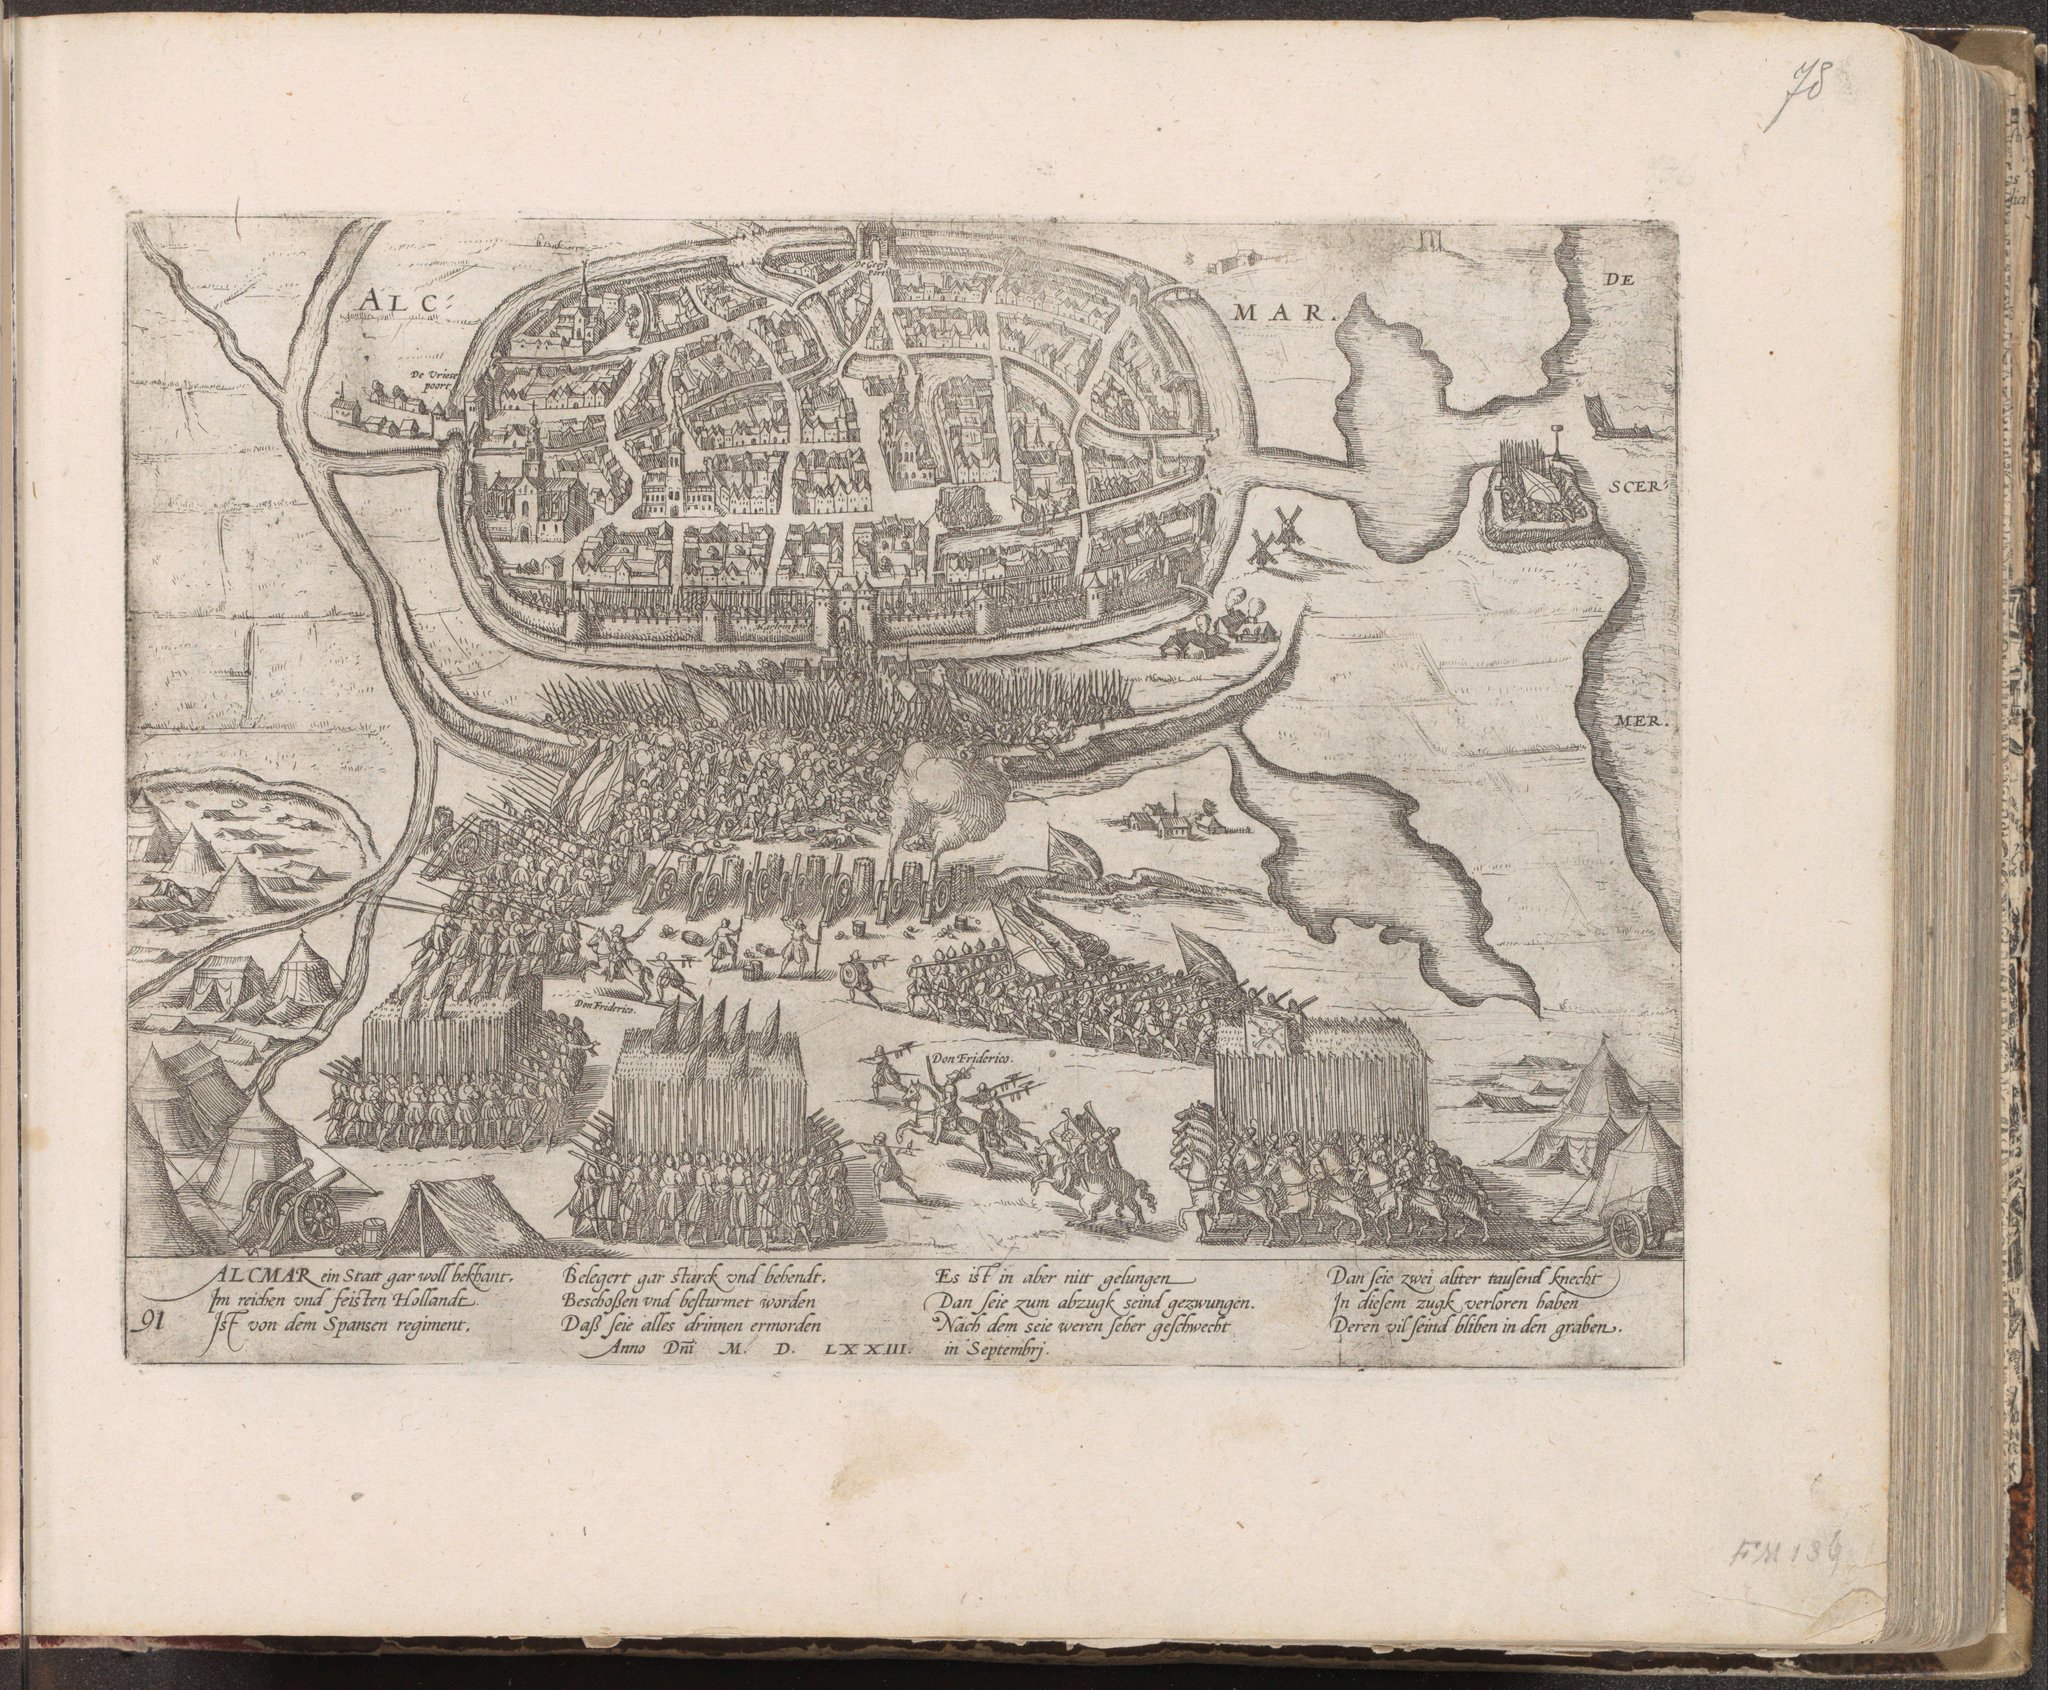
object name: album leaf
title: Beleg van Alkmaar, 1573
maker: frans hogenberg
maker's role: print maker, publisher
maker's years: 1538-1590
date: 1574-1578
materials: paper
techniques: etching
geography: cologne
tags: siege, position war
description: Plan van het beleg van Alkmaar, augustus en september 1573. Gezicht op de stad en het omringend gebied. Op de voorgrond de legerplaats van de belegerende troepen onder bevel van Don Frederik, rechts de Schermer. Met onderschrift van 12 regels in het Duits. Linksonder genummerd: 91. De prent maakt deel uit van een album.